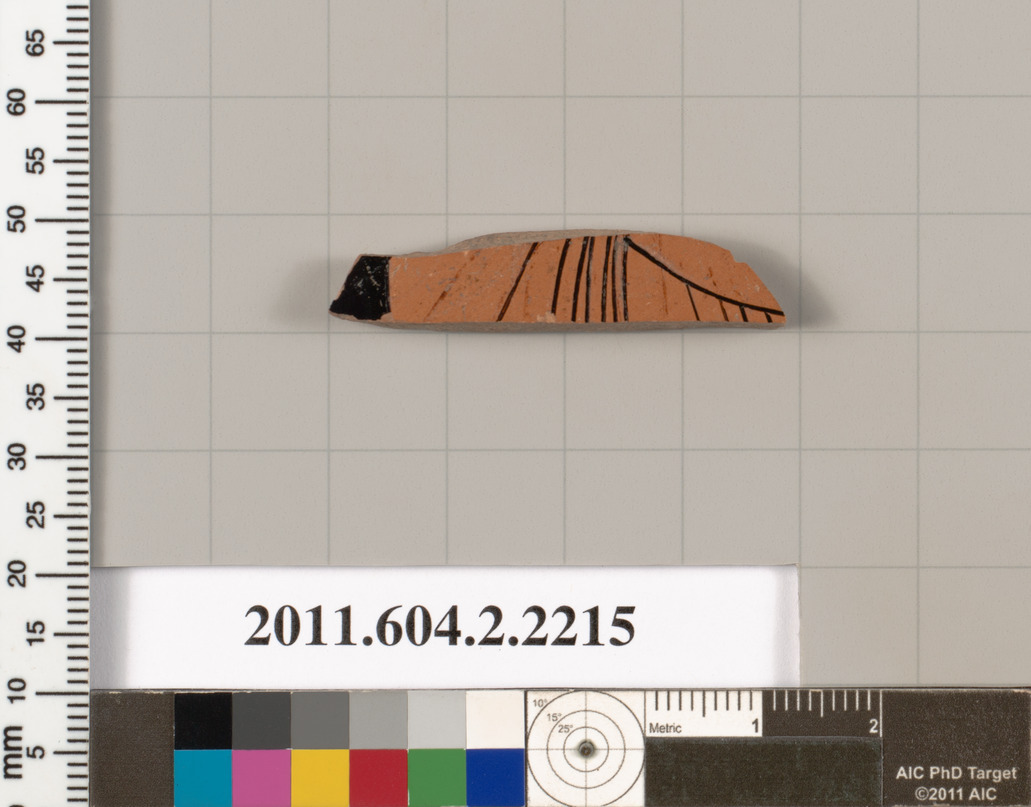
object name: pot fragment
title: Terracotta fragment of a pot; unglazed on the inside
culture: greek, attic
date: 460-440 BCE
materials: terracotta